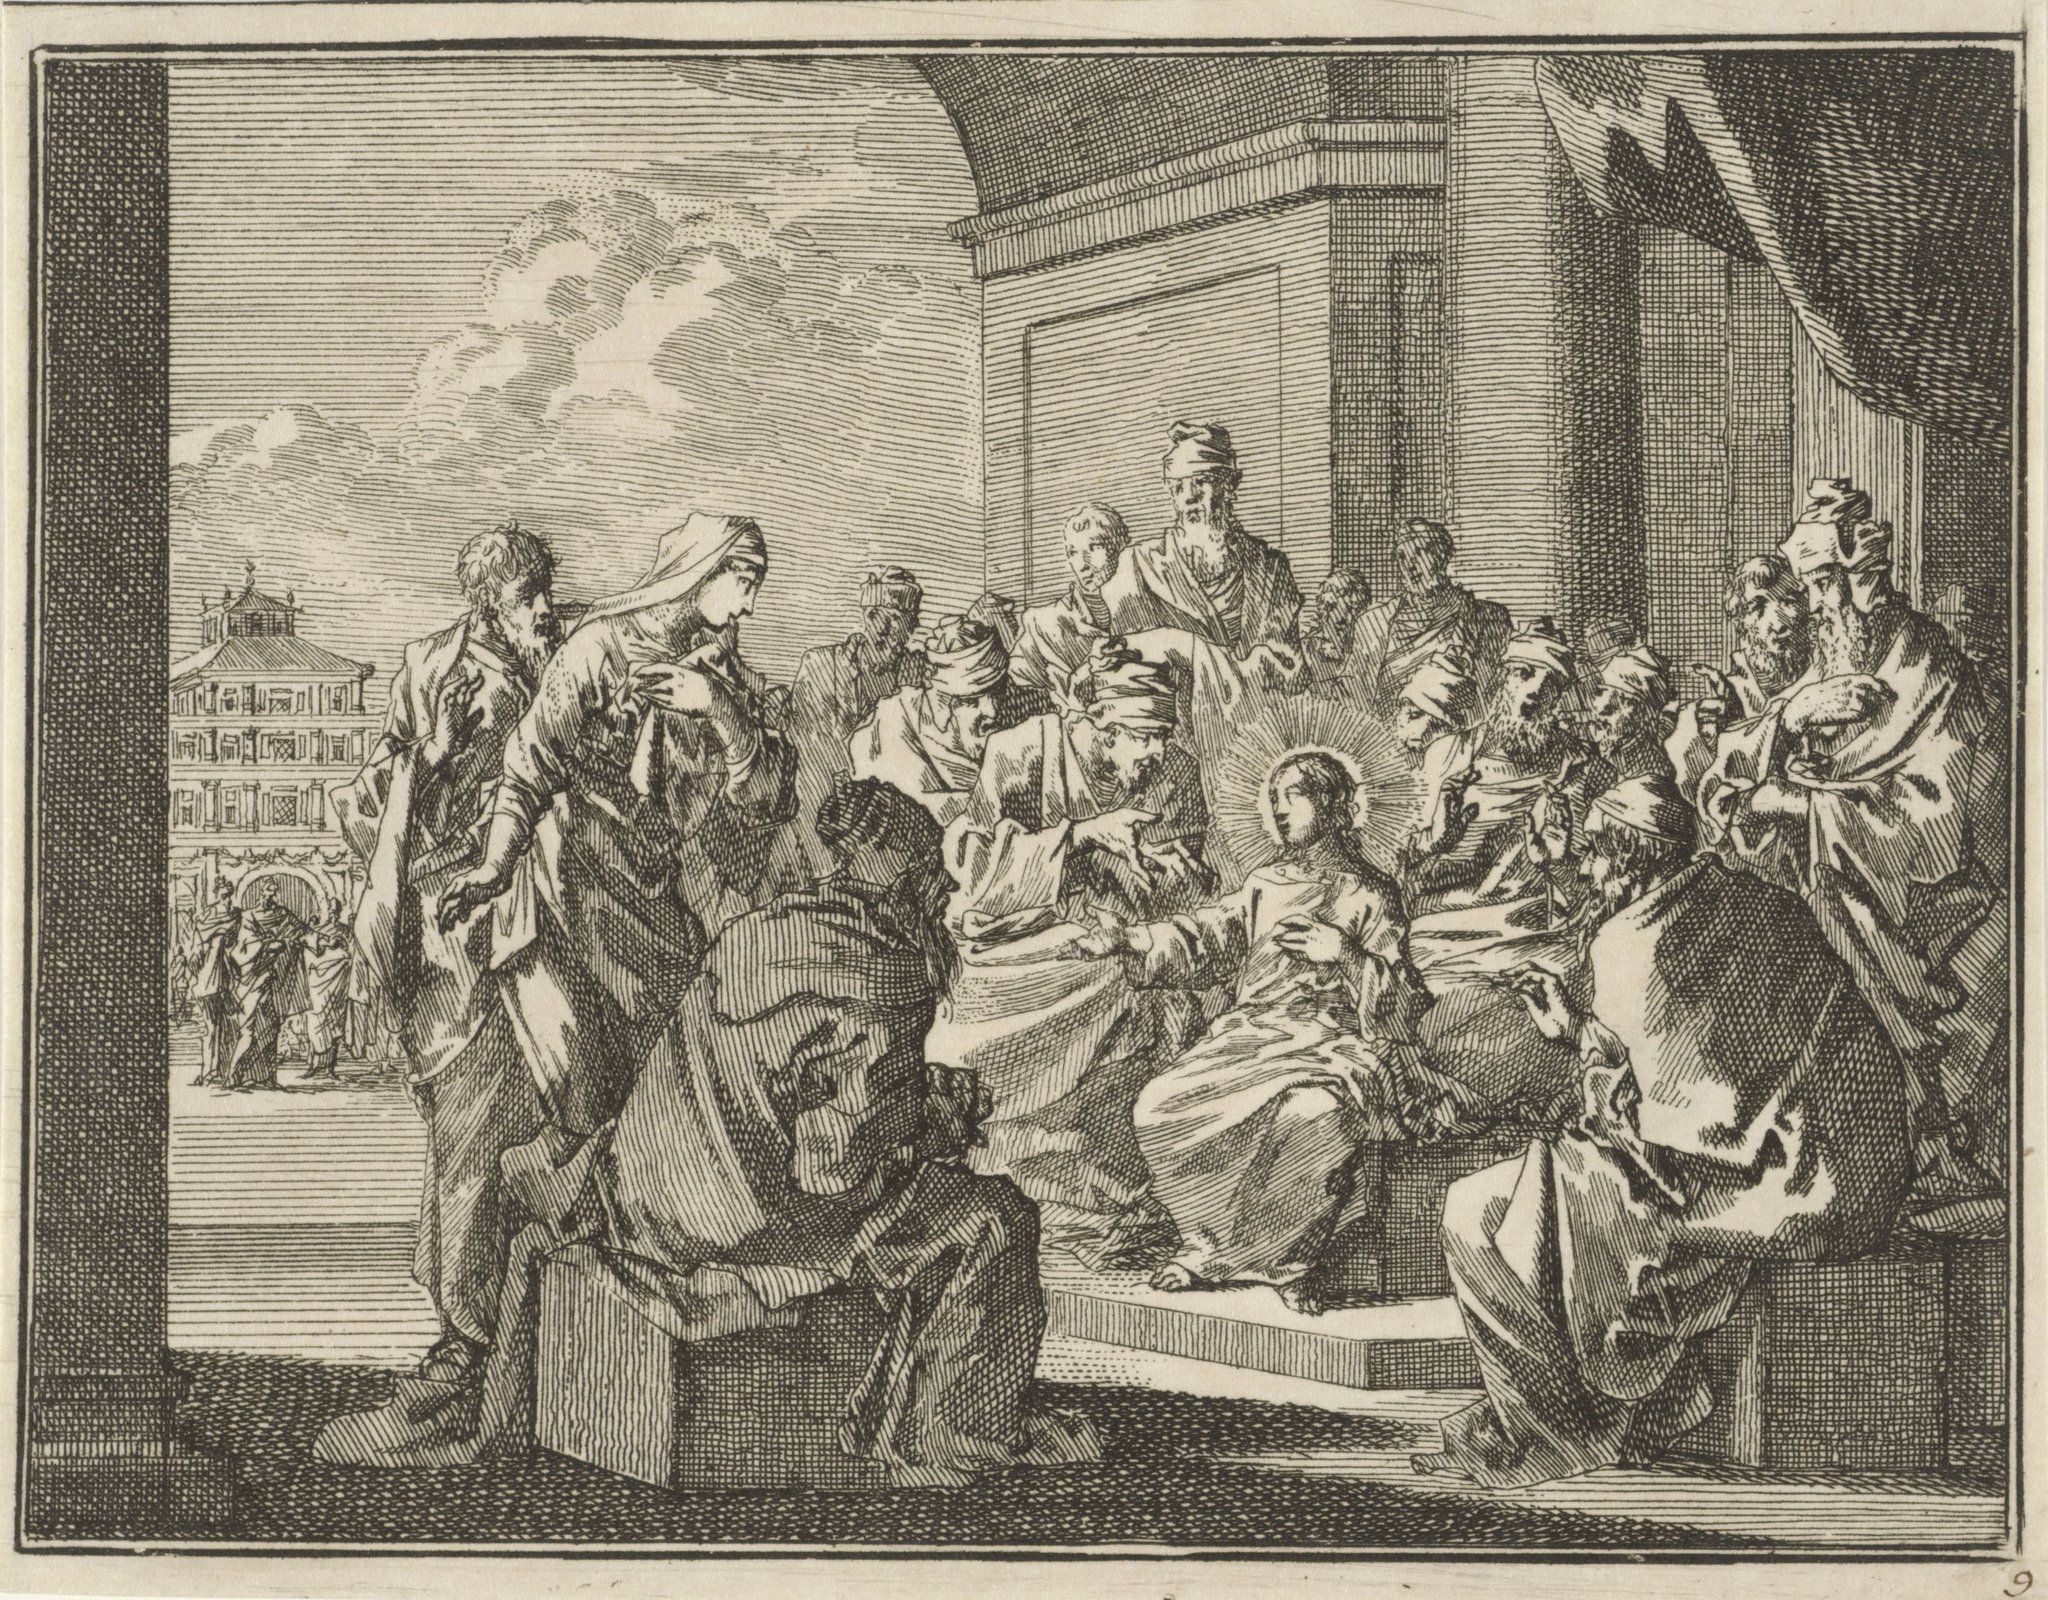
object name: print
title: Twaalfjarige Christus in de tempel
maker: jan luyken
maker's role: draughtsman, print maker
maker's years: 1649-1712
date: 1712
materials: paper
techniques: etching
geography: amsterdam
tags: christ's dispute with the doctors in the temple; he counts his arguments on his fingers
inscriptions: number: ‘9’, collector's mark: Lugt 2228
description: Proefdruk van illustratie uit: Luyken, Jan. De schriftuurlyke geschiedenissen en gelykenissen van het Oude en Nieuwe Verbond, 2 delen. Amsterdam: Wed. Pieter Arentsz II en Cornelis van der Sys, 1712, dl. II.